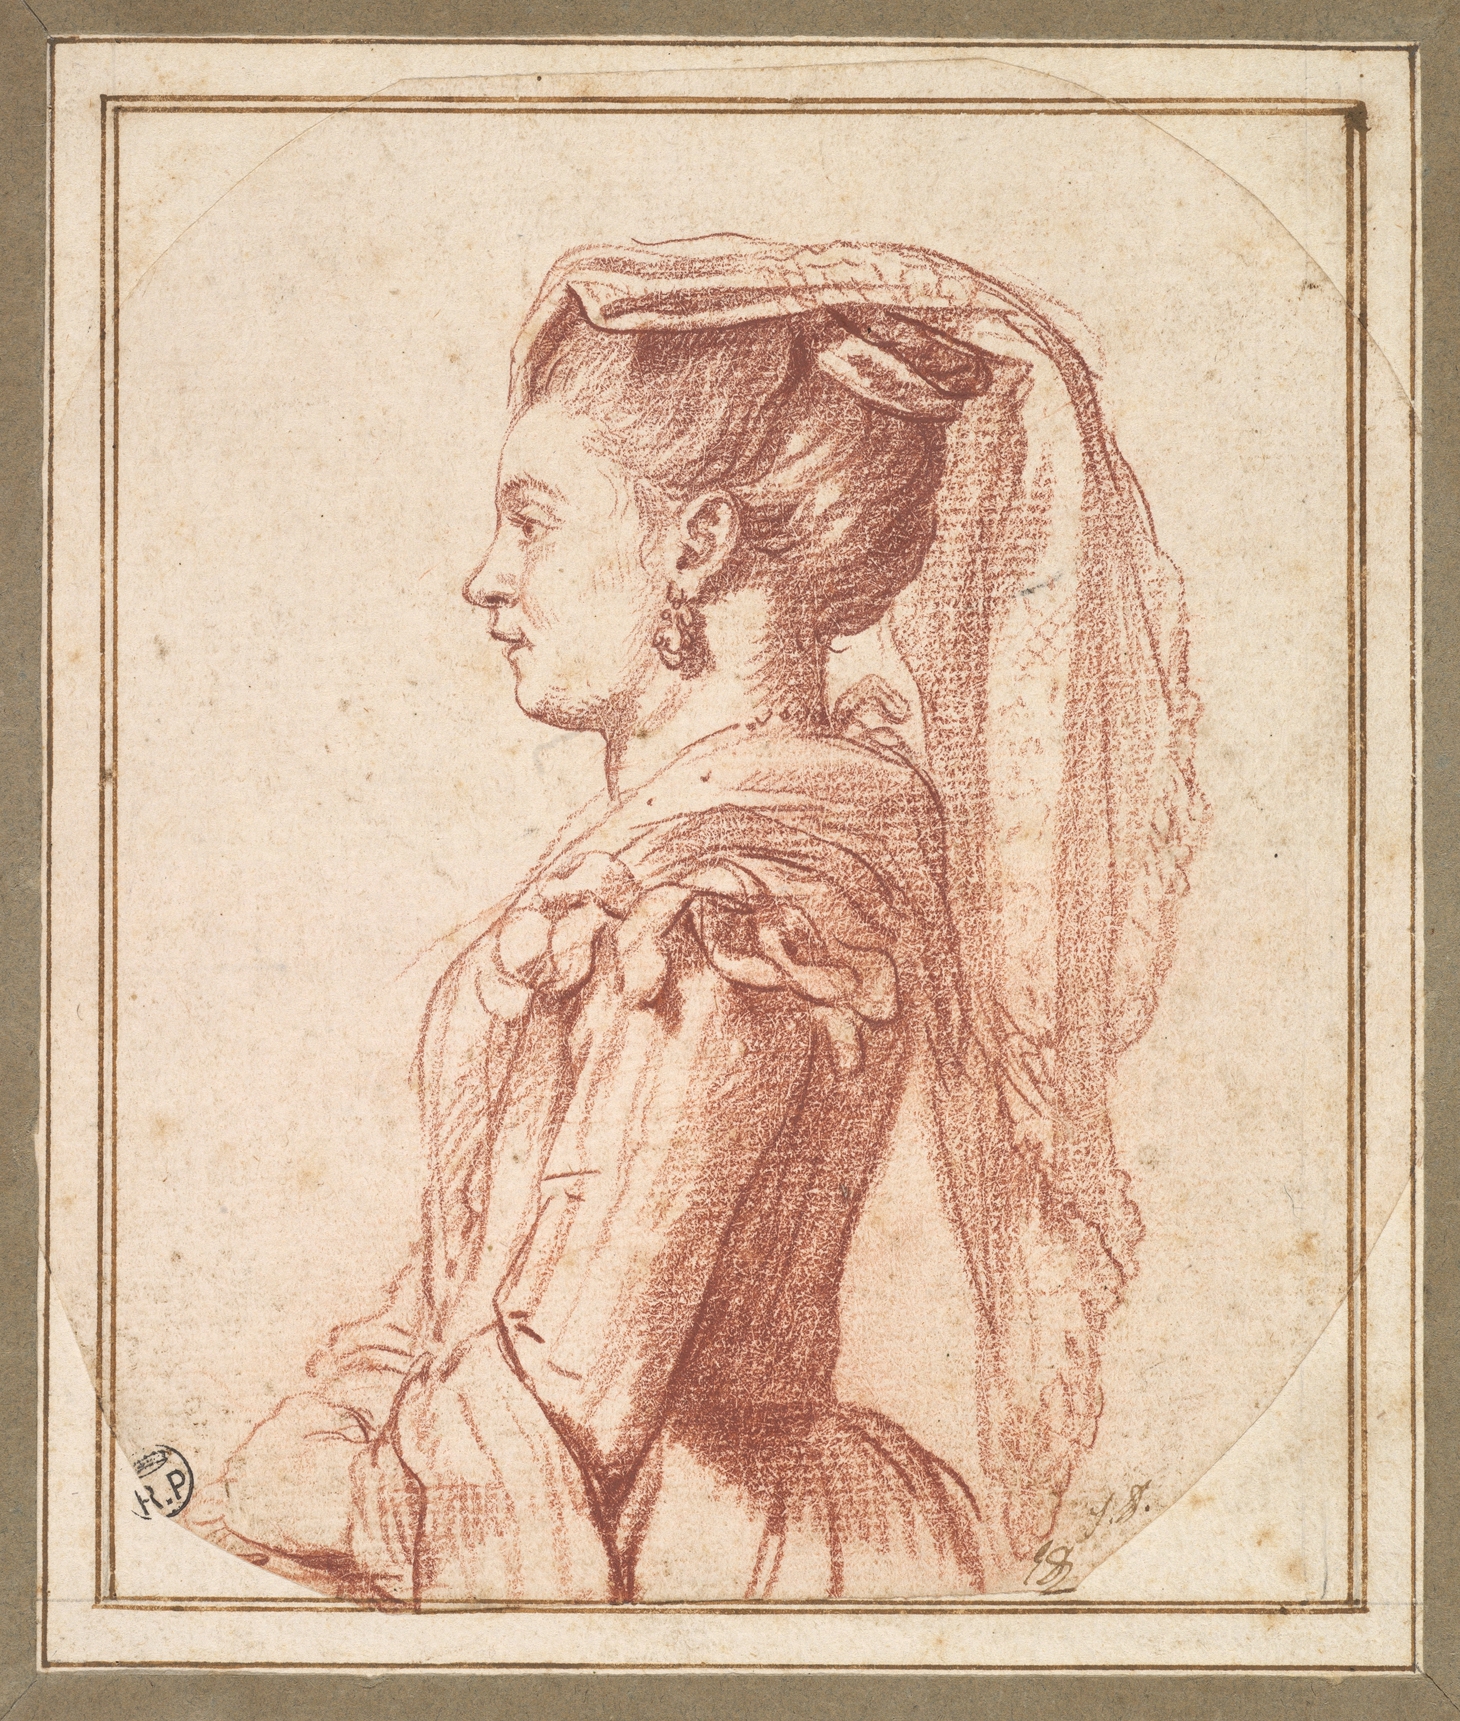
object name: drawing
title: A Young Woman of Frascati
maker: jacques louis david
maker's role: artist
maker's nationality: french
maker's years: 1748-1825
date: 1775-1776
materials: chalk, ink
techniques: cutting, pen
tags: profiles,women